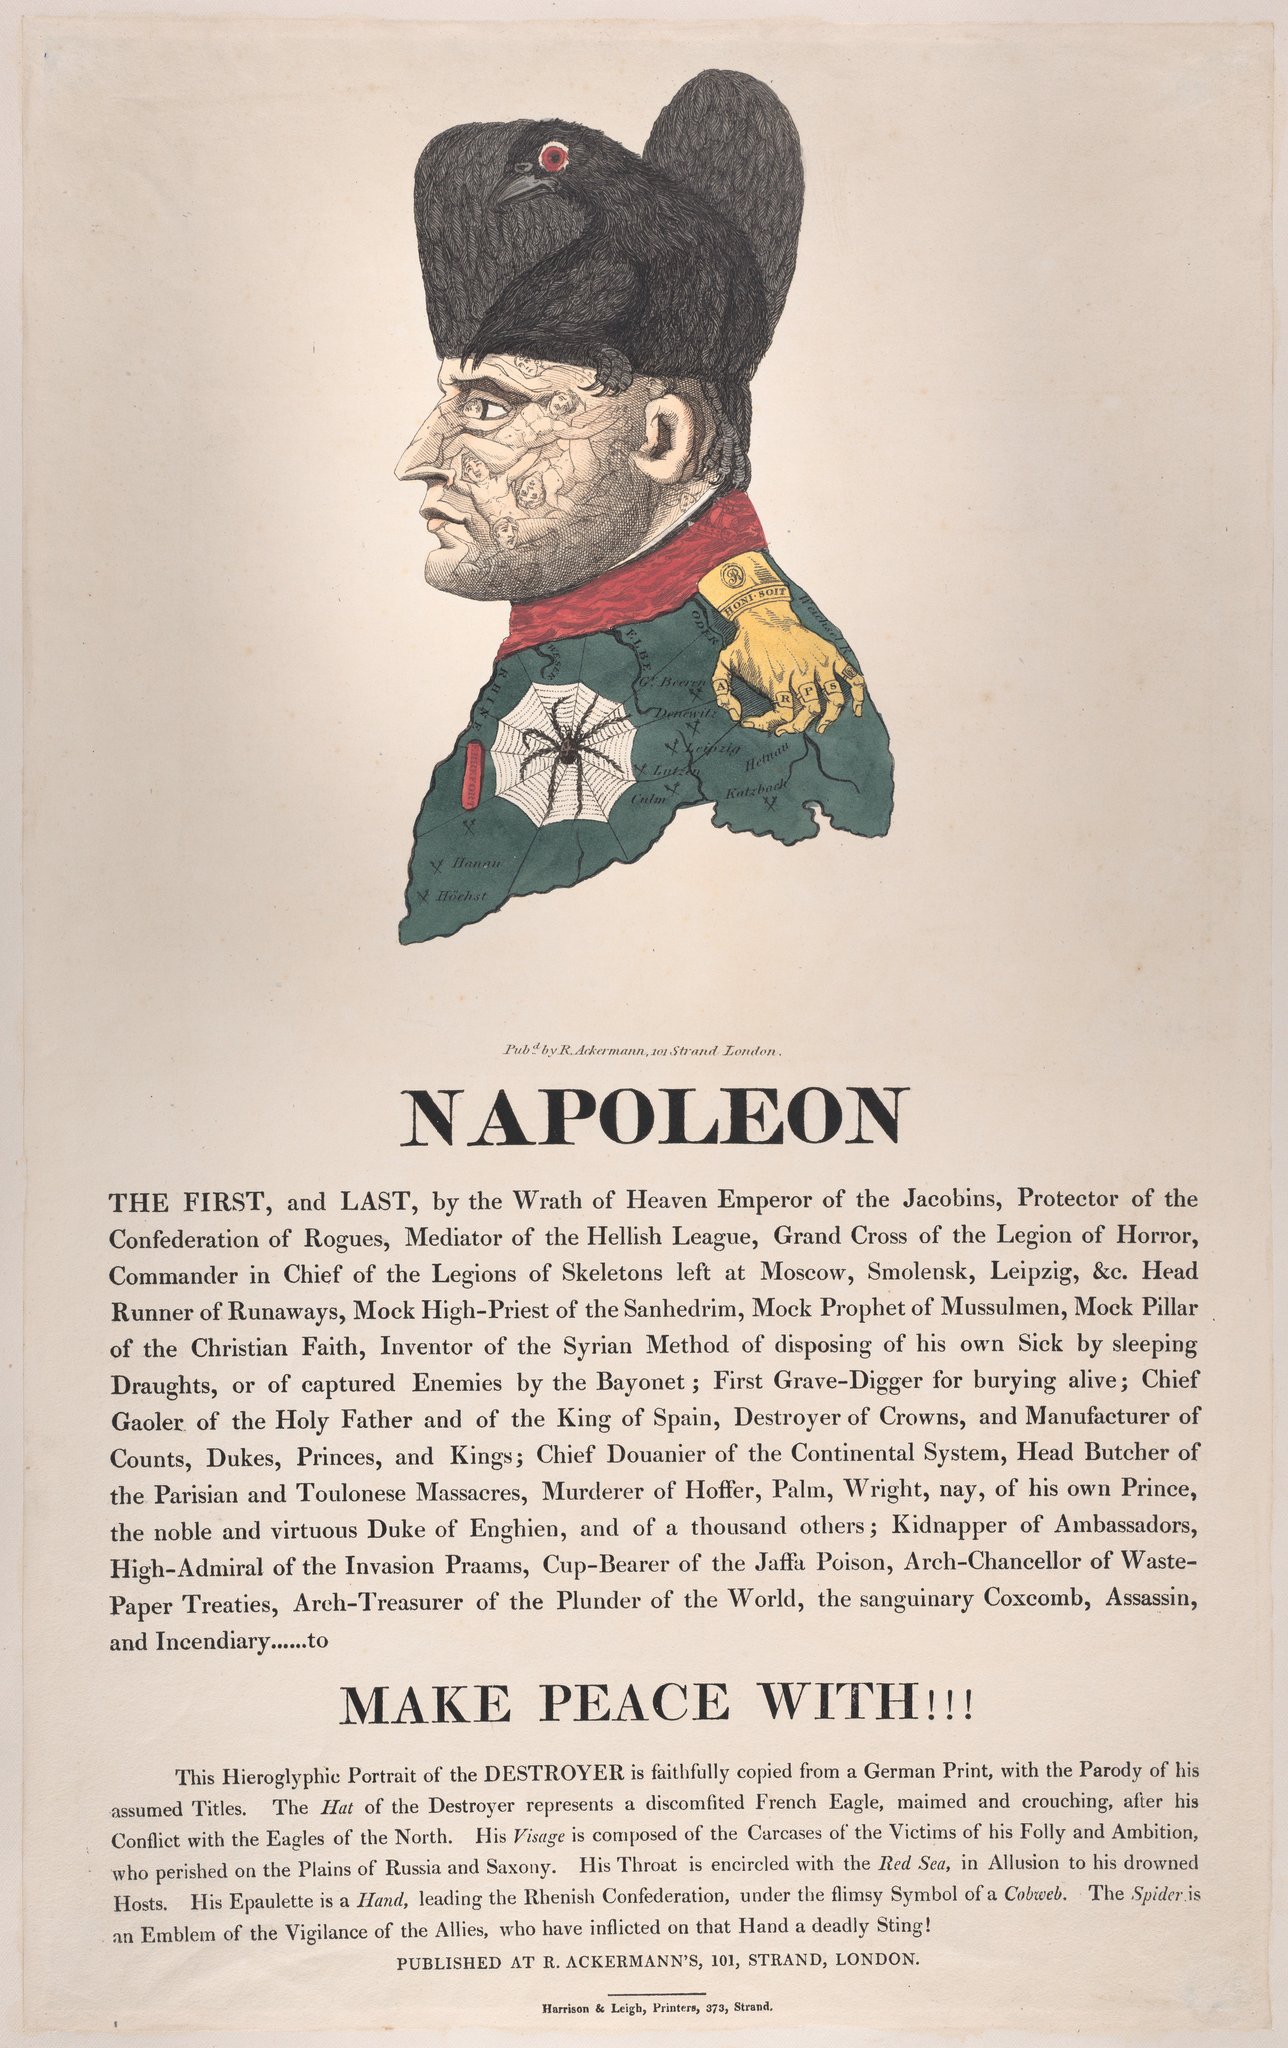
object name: print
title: Napoleon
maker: thomas rowlandson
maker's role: artist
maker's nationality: british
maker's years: 1757-1827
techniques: etching, letterpress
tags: eagles,satire,napoleon i,spiders,politics